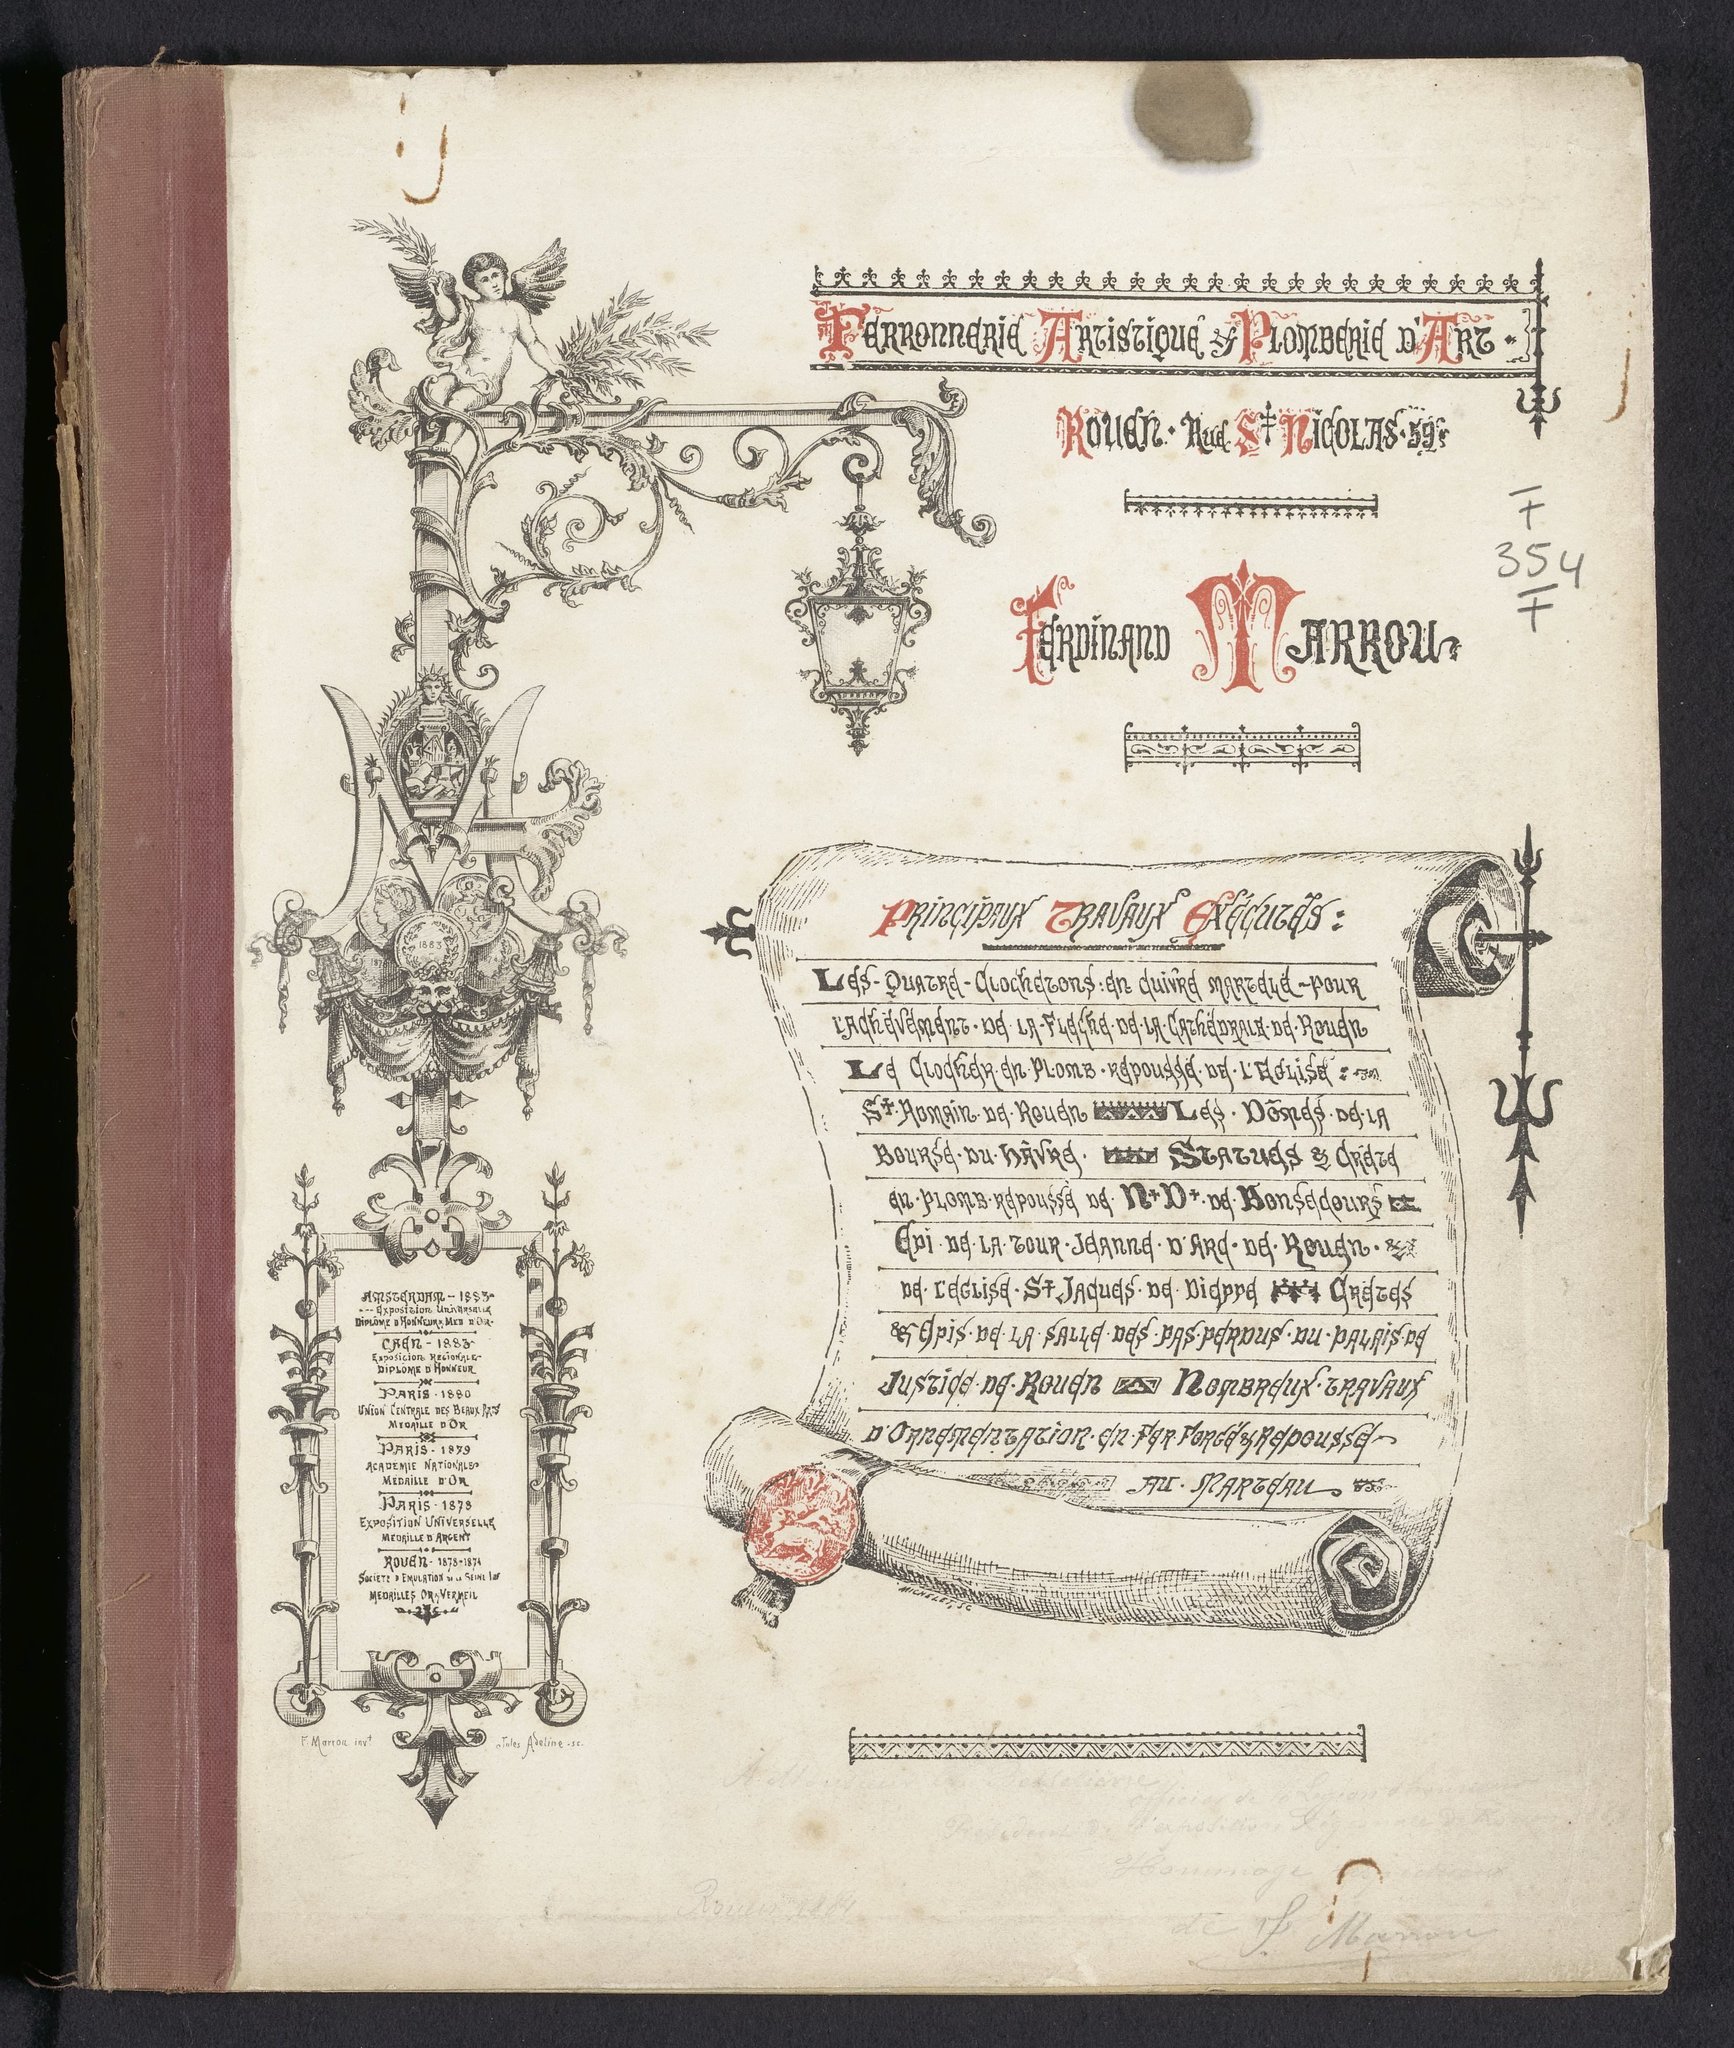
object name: book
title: Ferronnerie artistique et plomberie d'art Ferdinand Marrou principaux traveaux excluses : les quatre clocherons en cuivre martelé pour l'achèvement de la fleche de la cathédrale de Rouen .... [etc.]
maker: ferdinand marrou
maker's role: schrijver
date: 1884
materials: cardboard, linen, paper, photographic support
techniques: albumen print, printing